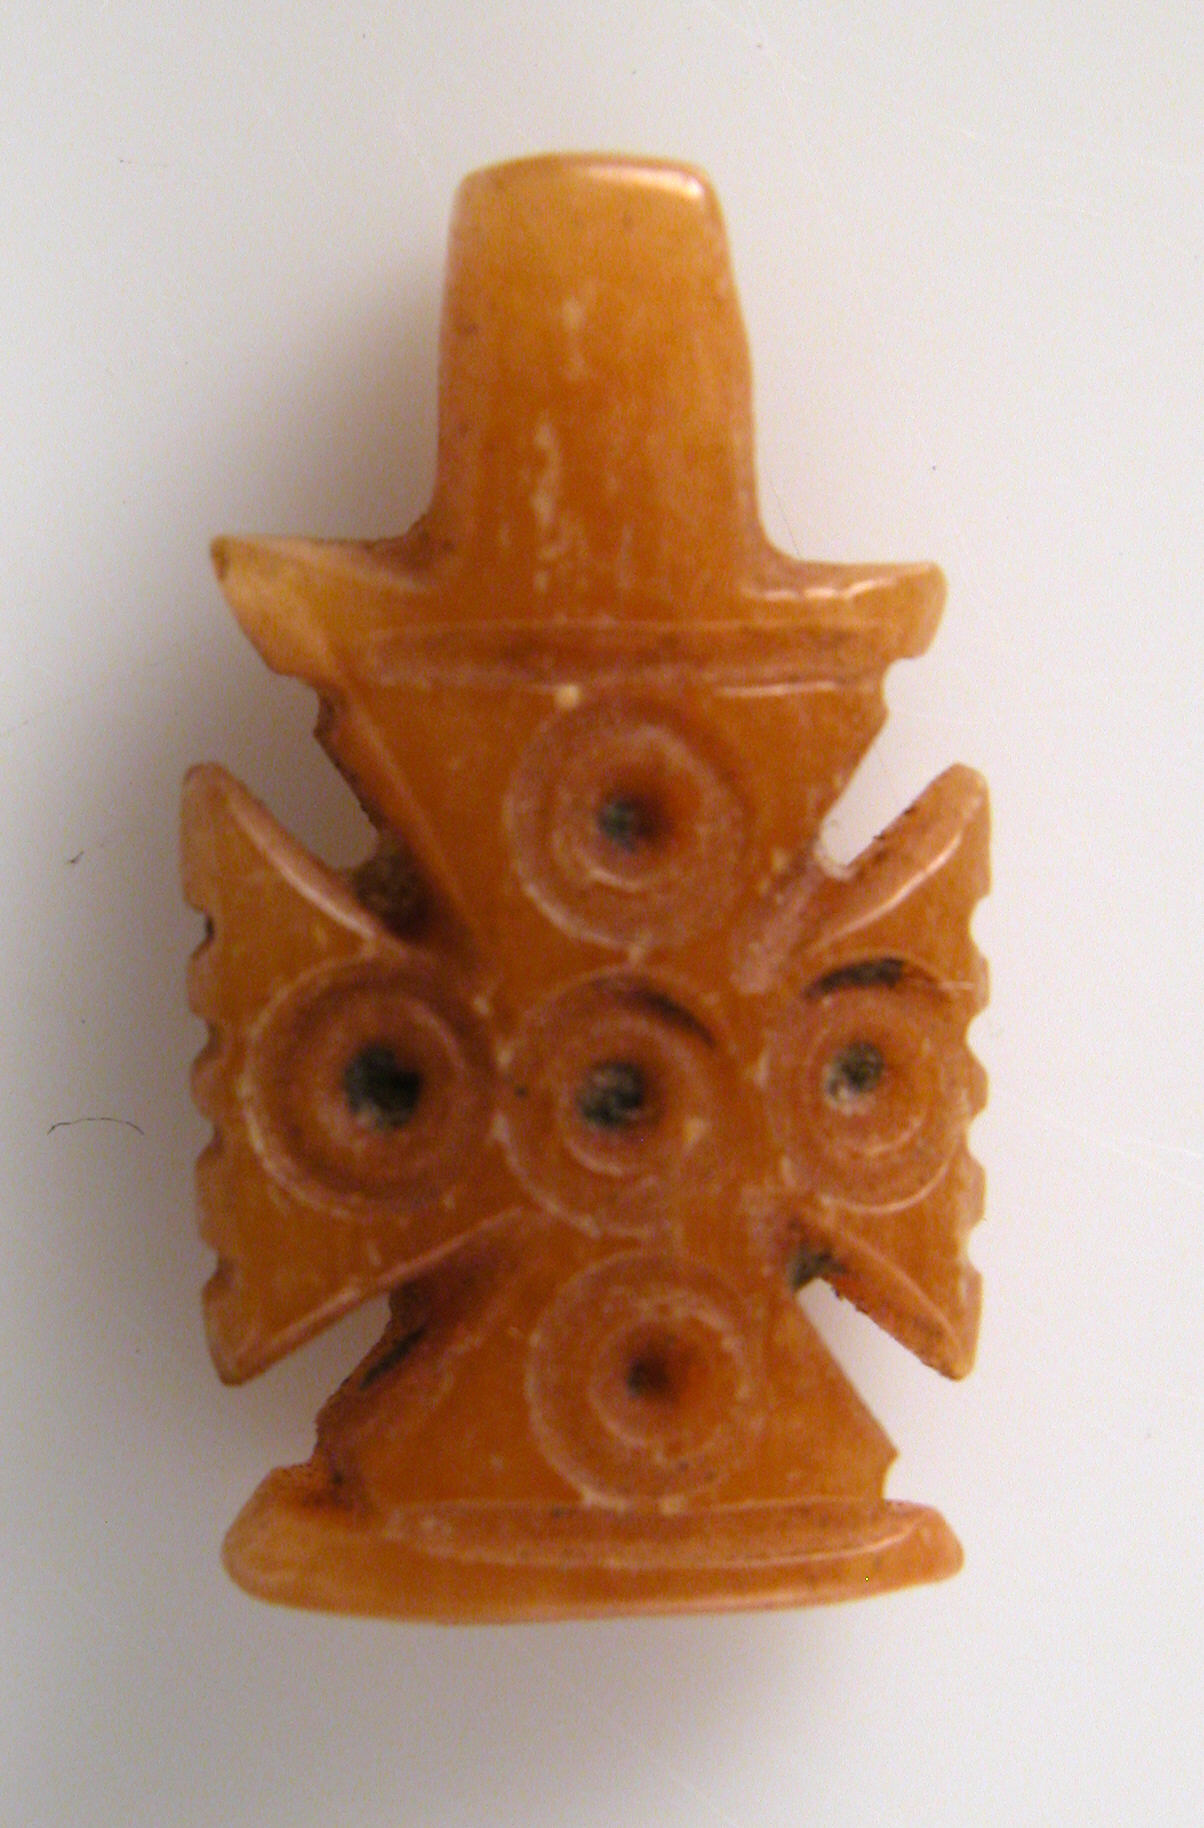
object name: pendant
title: Pendant Cross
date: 401-700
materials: bone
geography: egypt